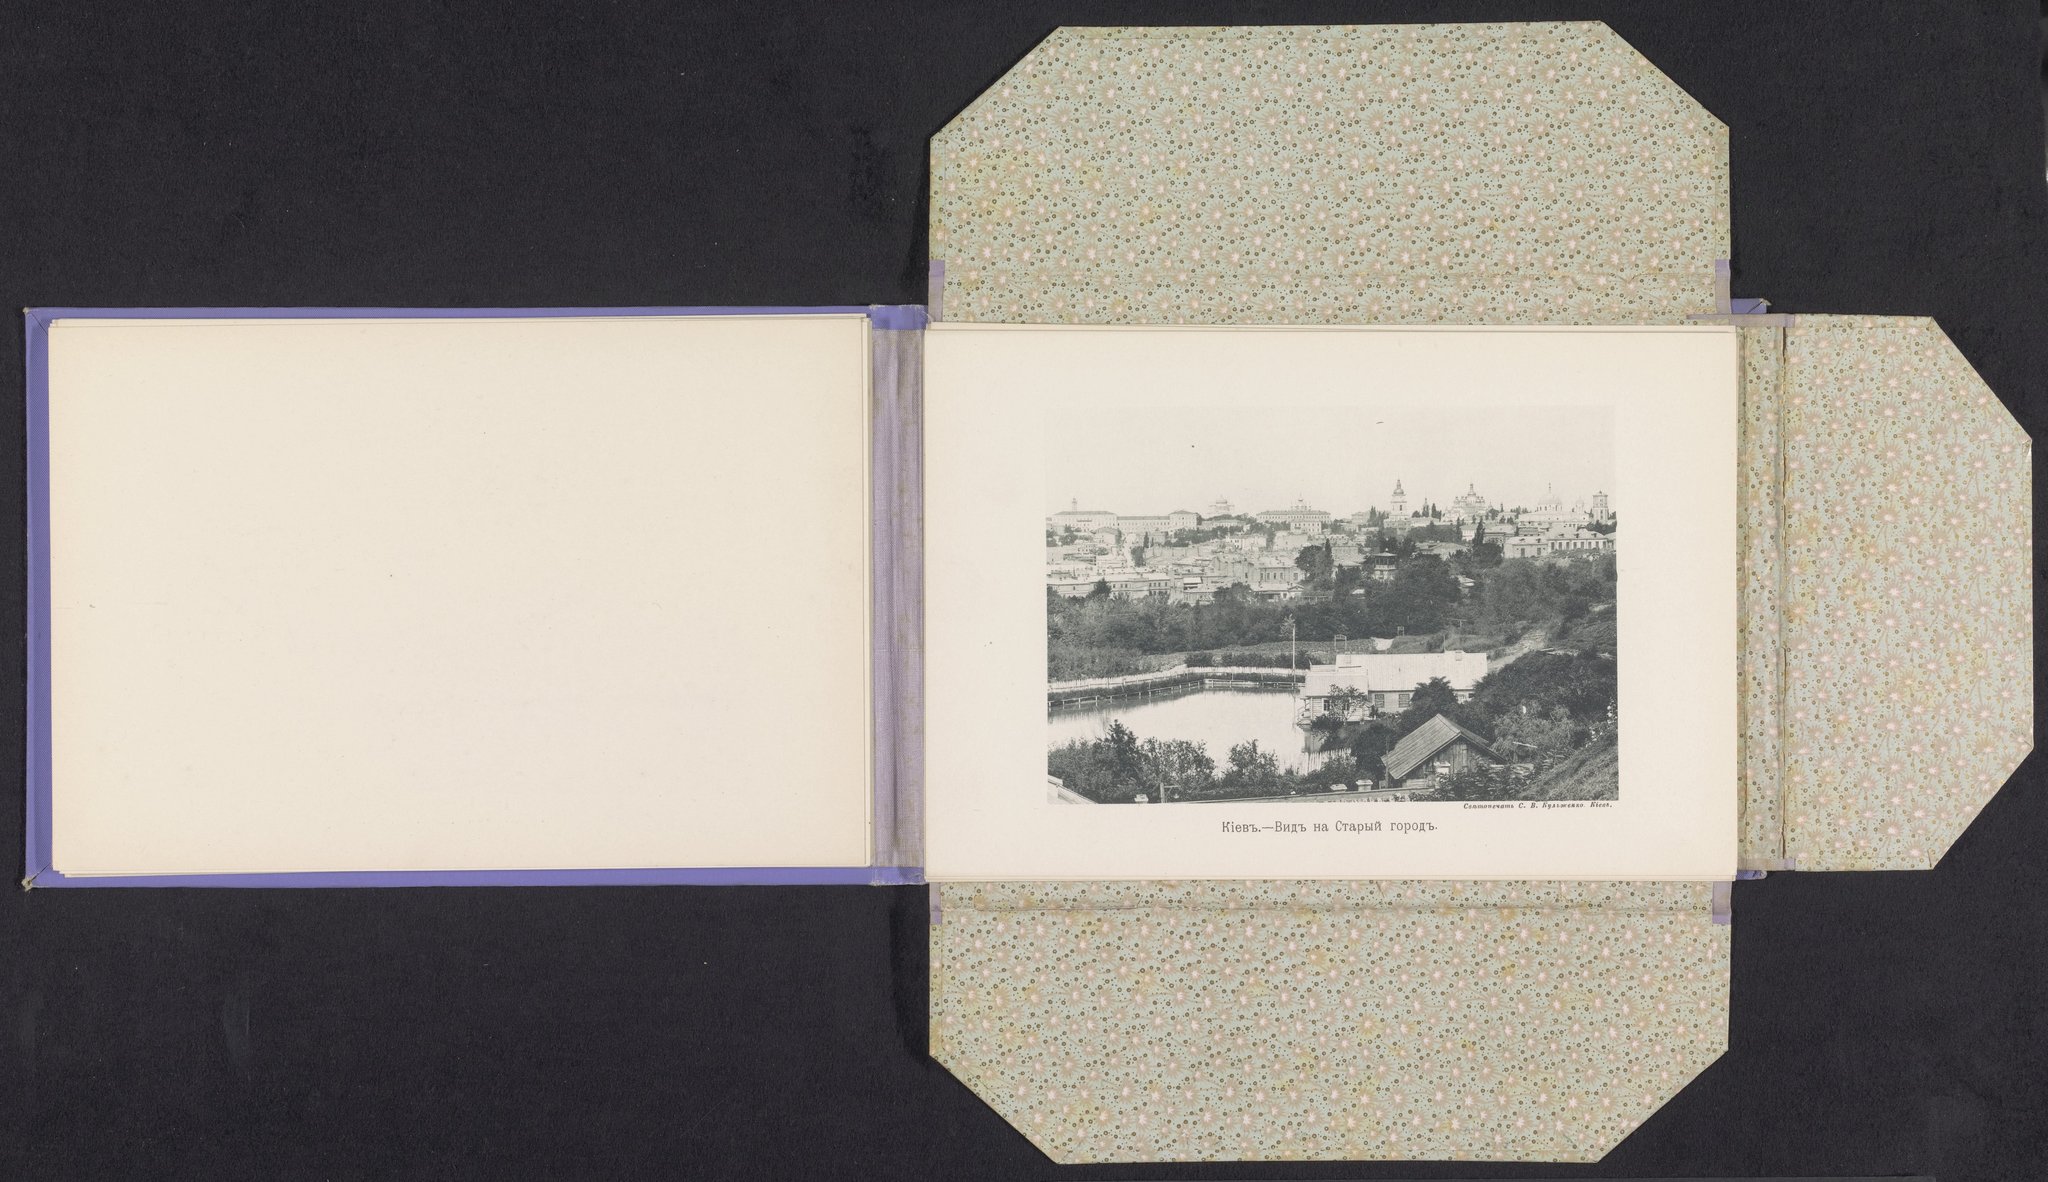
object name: photomechanical print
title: Kieвъ.- Вилдъ нa Стapый гopoдъ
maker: Anonymous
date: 1886-1896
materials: paper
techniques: photograph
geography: kyiv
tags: grave, tomb